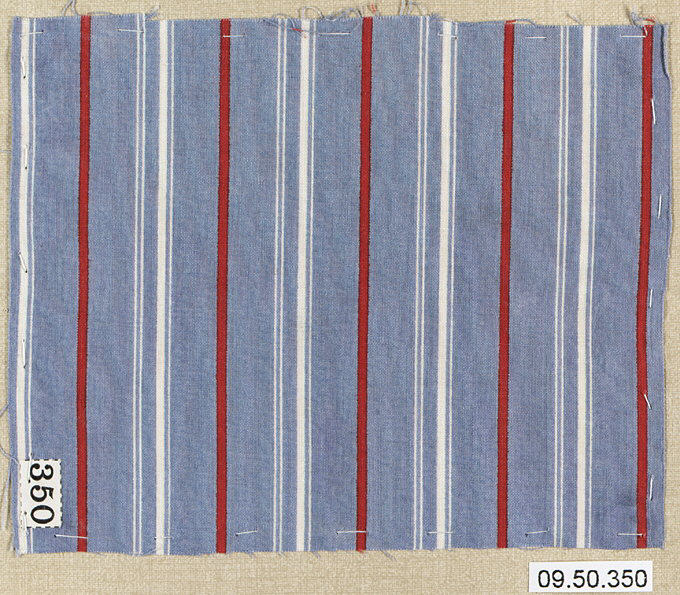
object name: piece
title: Piece (one of 116)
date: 1801-1900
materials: cotton